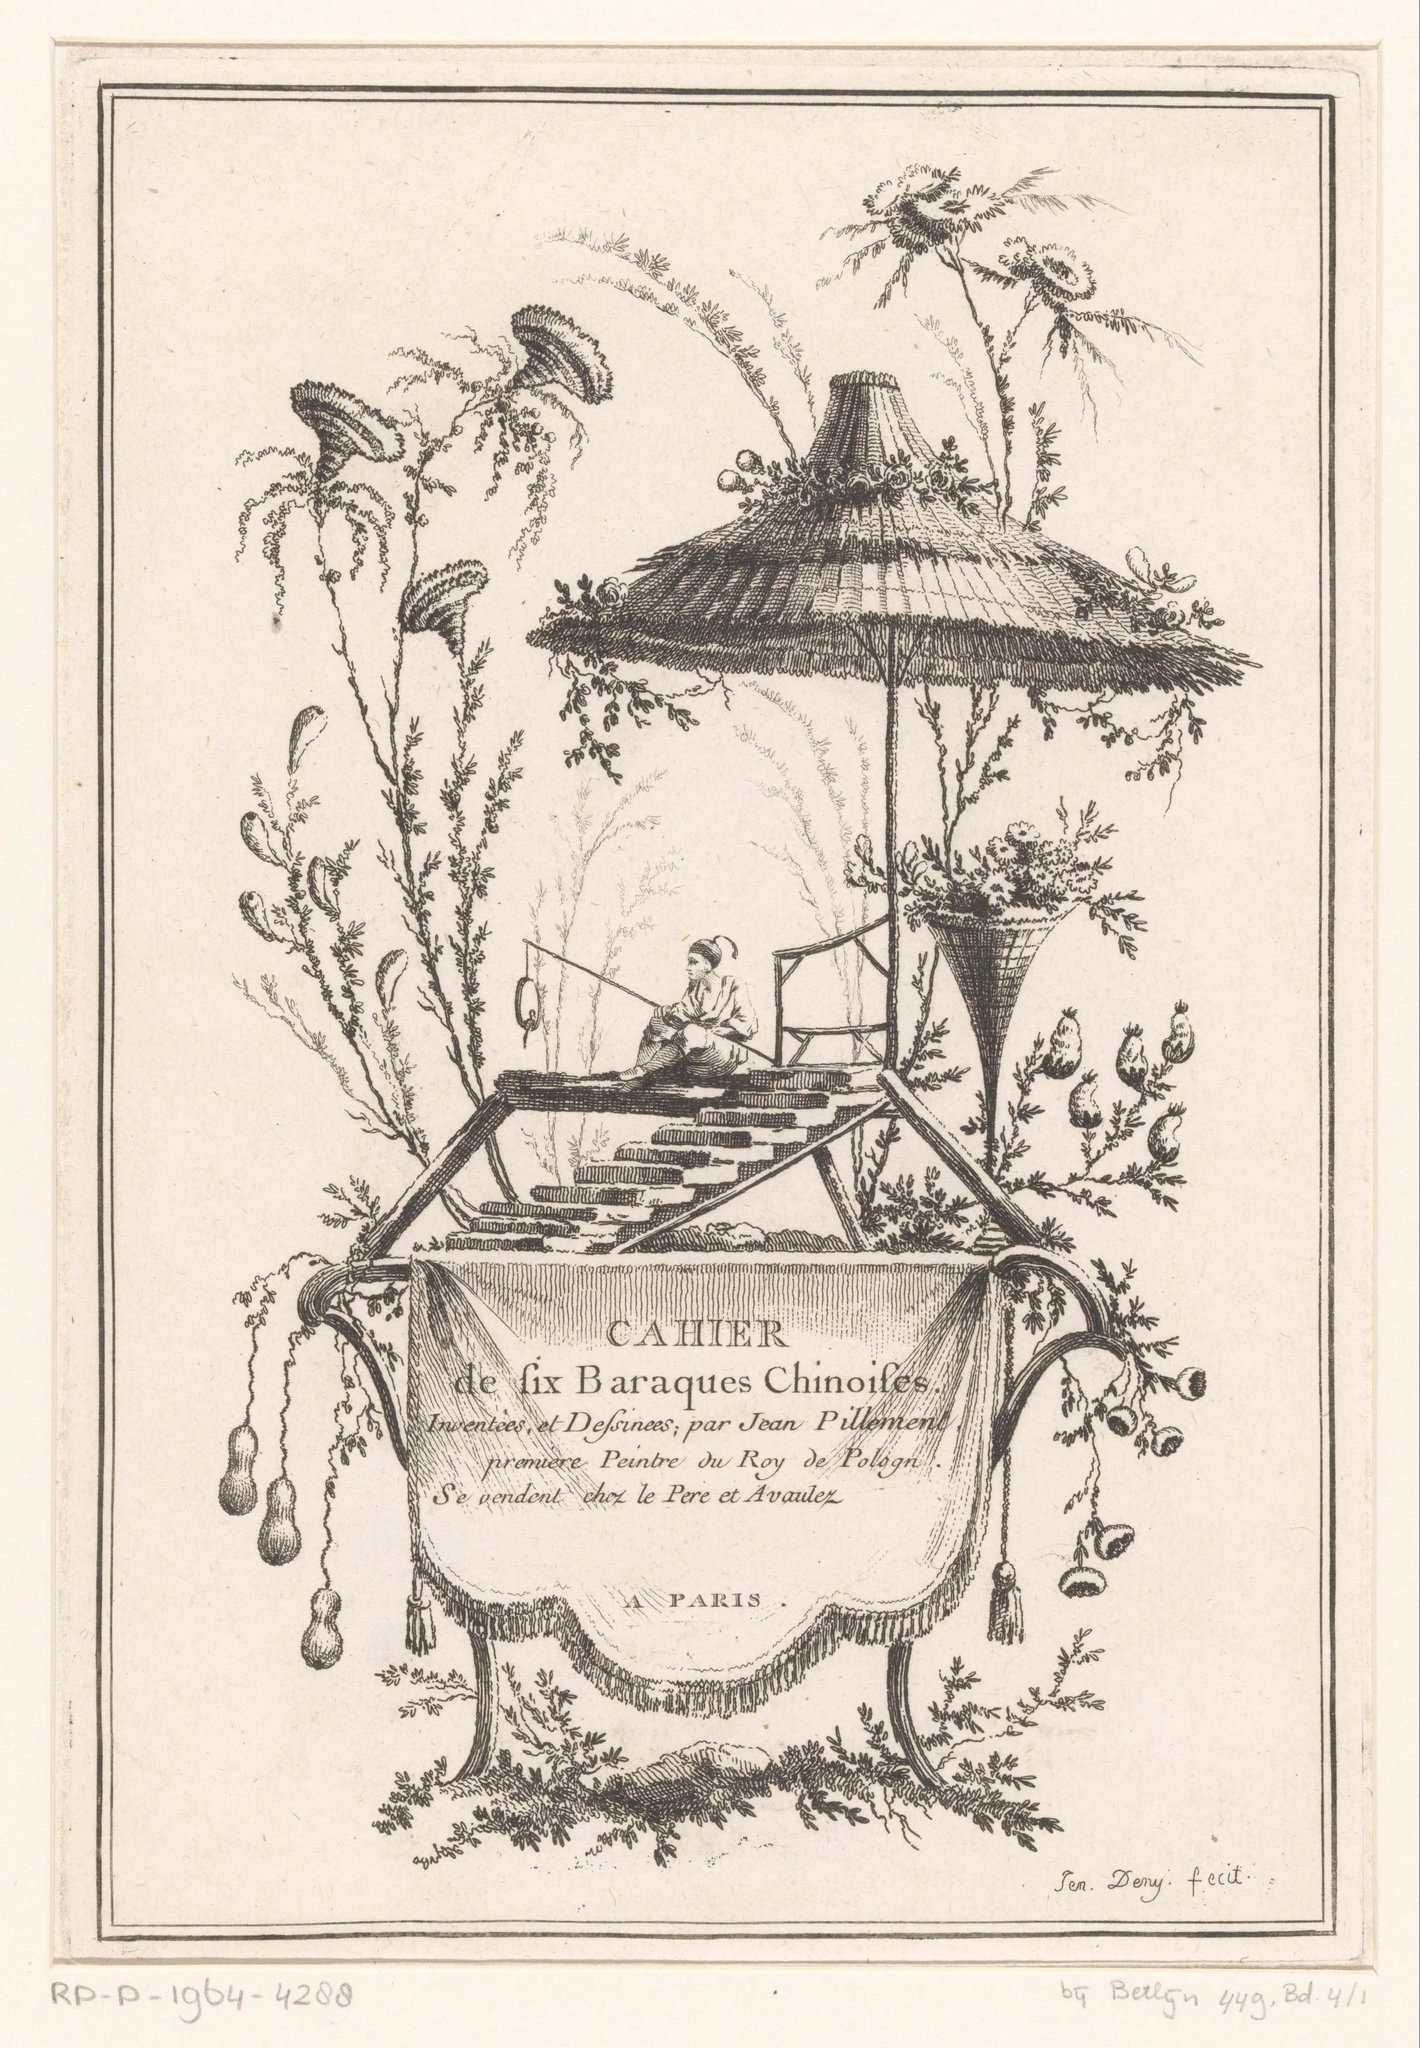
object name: print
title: Cahier de six Baraques Chinoises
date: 1772-1779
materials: paper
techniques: etching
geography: paris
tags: sitting figure, shed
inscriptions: collector's mark: Lugt 2760, collector's mark: Lugt 2228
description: In een landschap zit een man naast een trap onder een parasolvormig afdak. Hij houdt een stok met ronde vorm in zijn hand. Aan de voorzijde de serietitel.